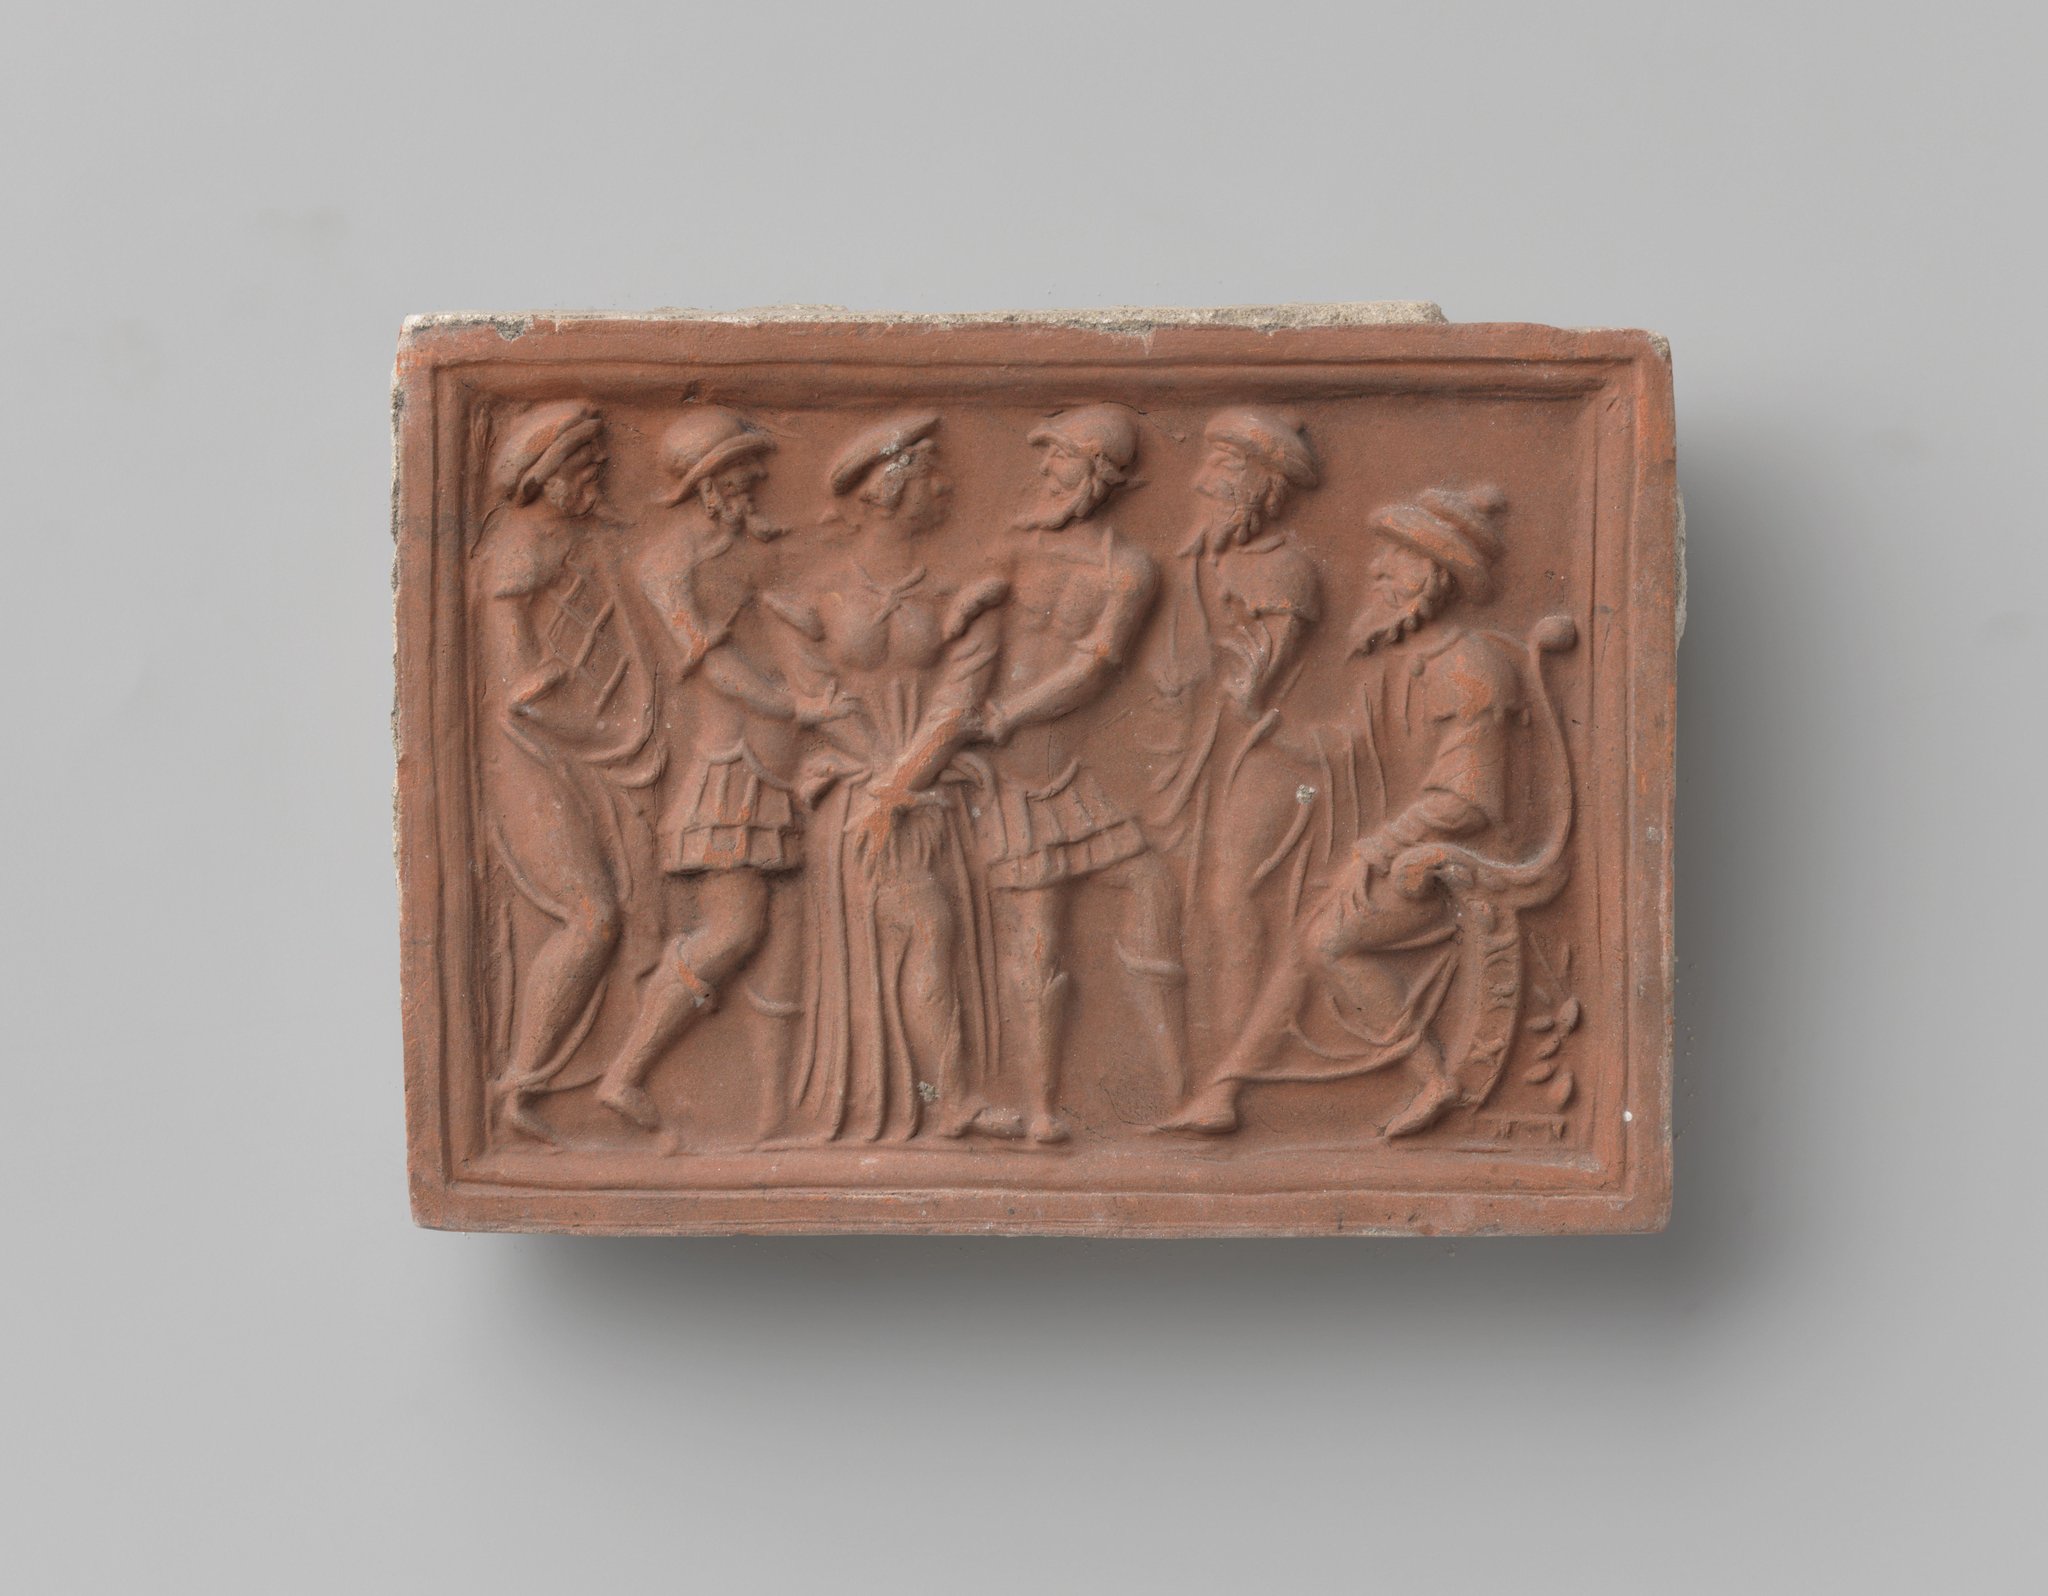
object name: hearthstone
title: Haardsteen met voorstelling van Suzanna, die door de twee ouderlingen voor de rechter wordt gevoerd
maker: Anonymous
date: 1875-1900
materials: earthenware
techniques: printing, firing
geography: netherlands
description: Haardsteen met voorstelling van Suzanna, die door de twee ouderlingen voor de rechter wordt gevoerd.